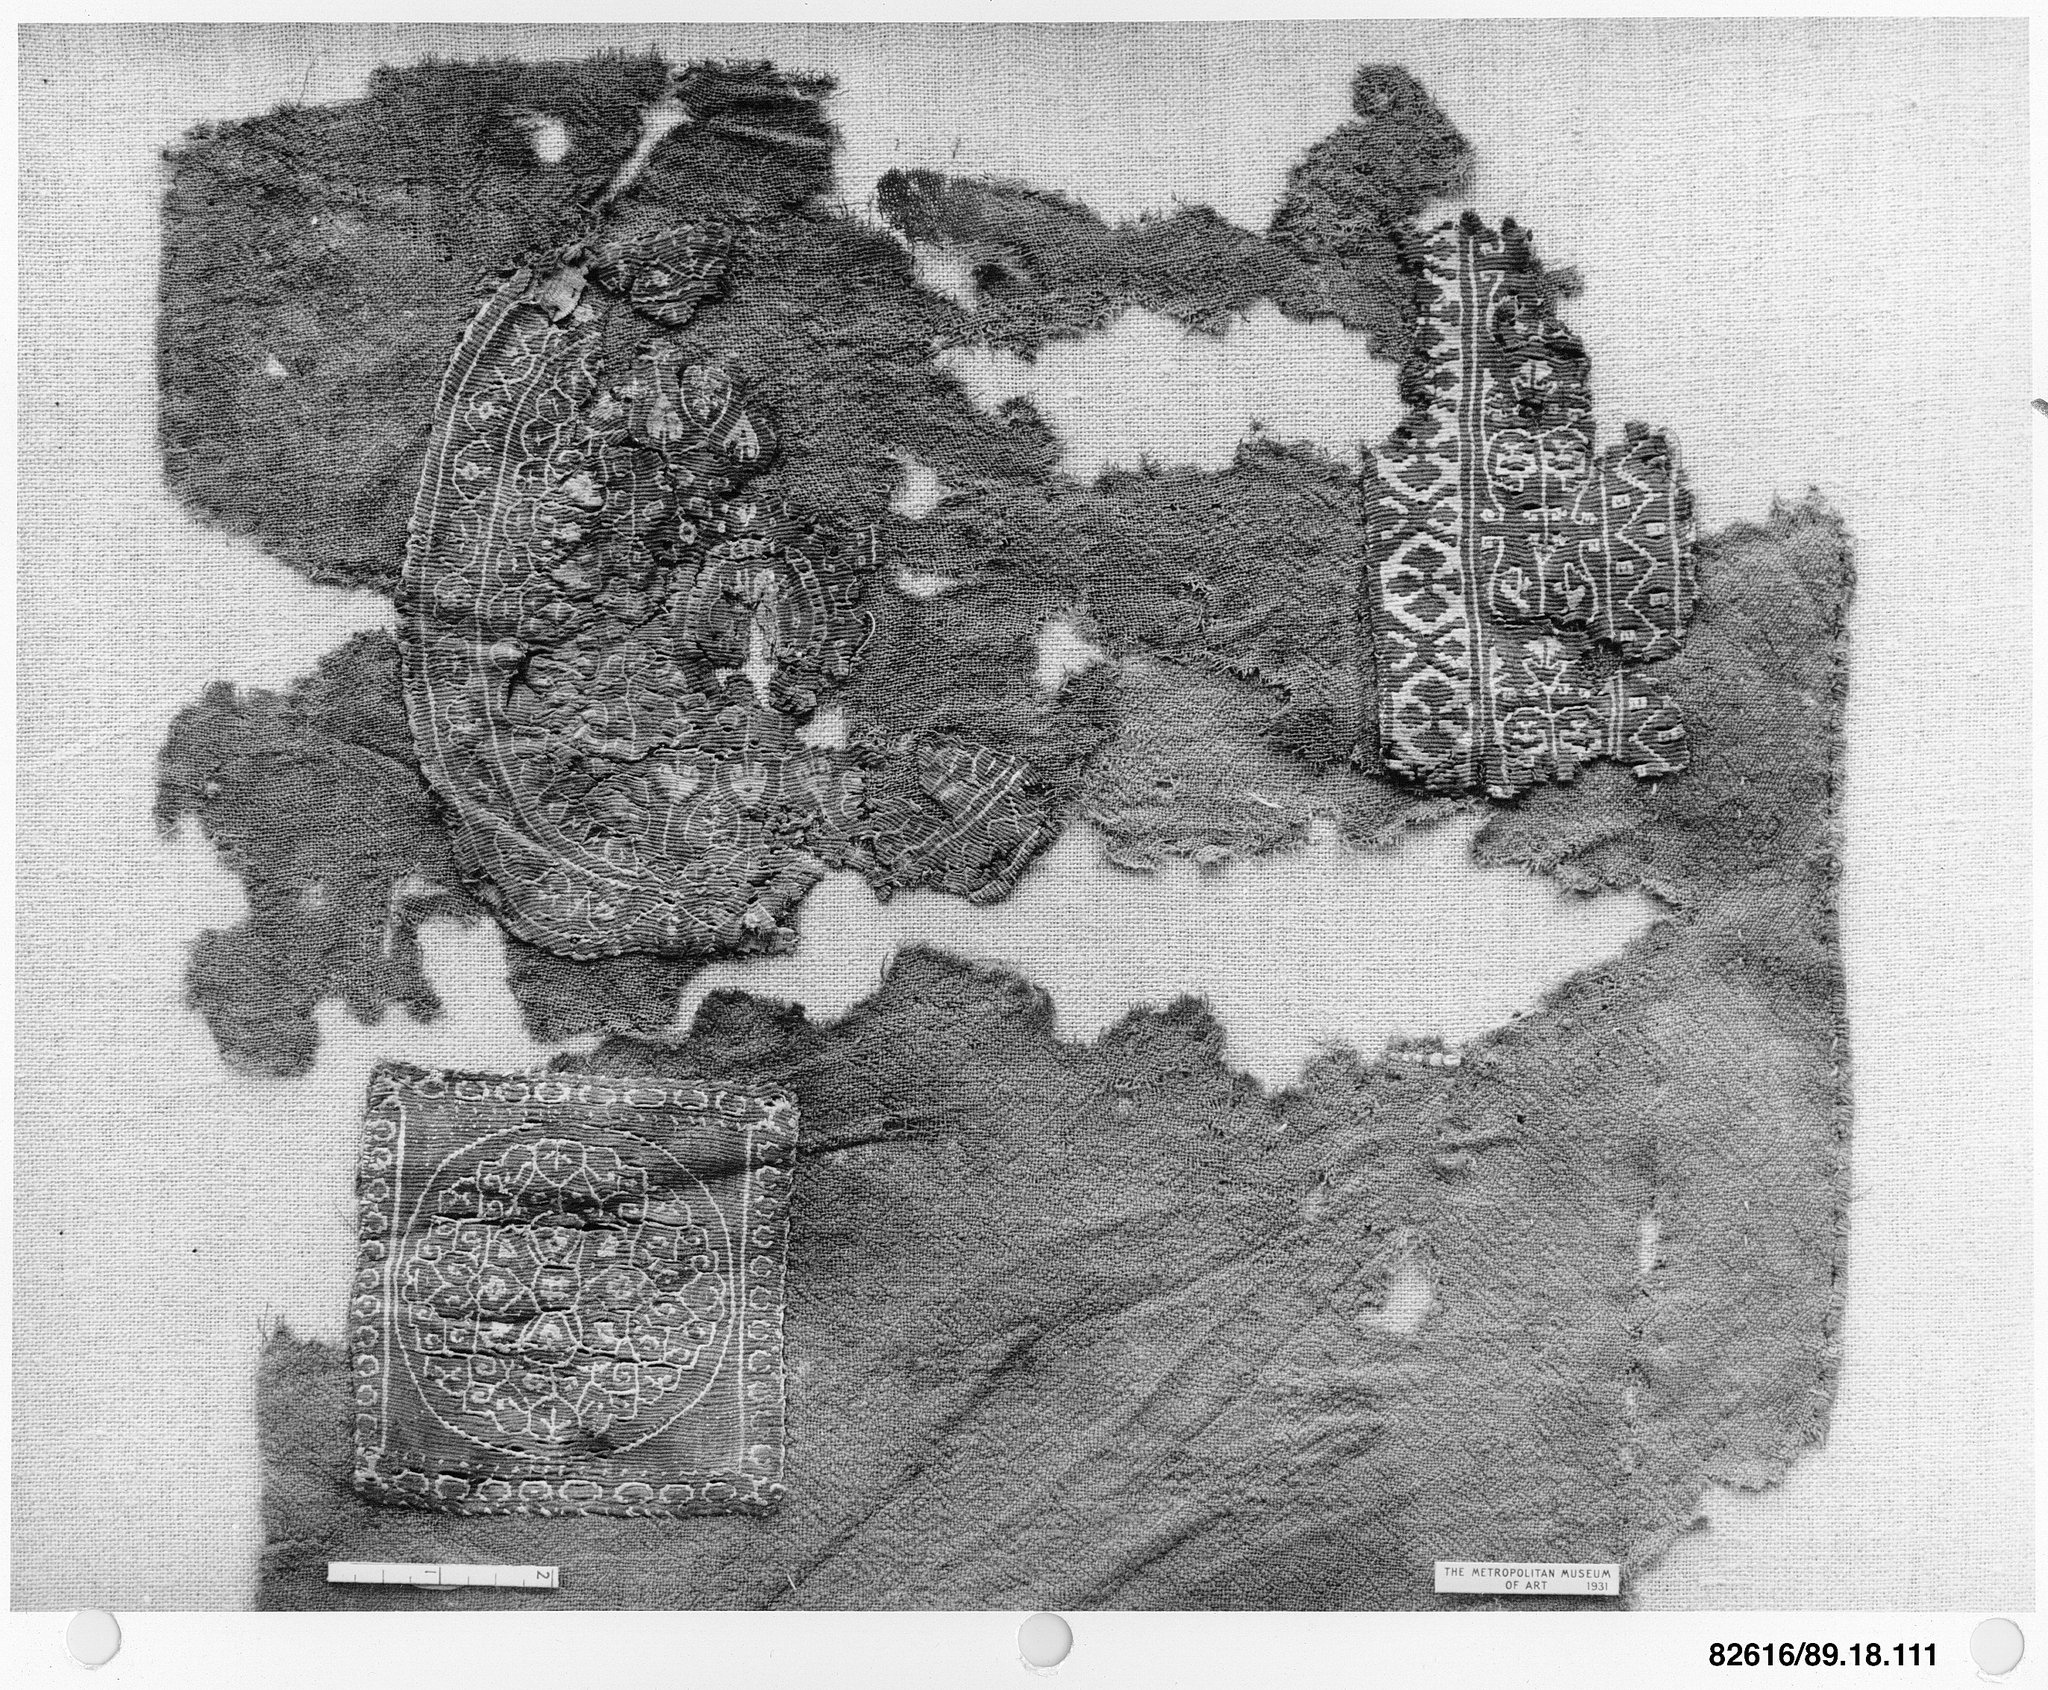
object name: textile fragment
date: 401-600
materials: linen, wool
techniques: weave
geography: egypt